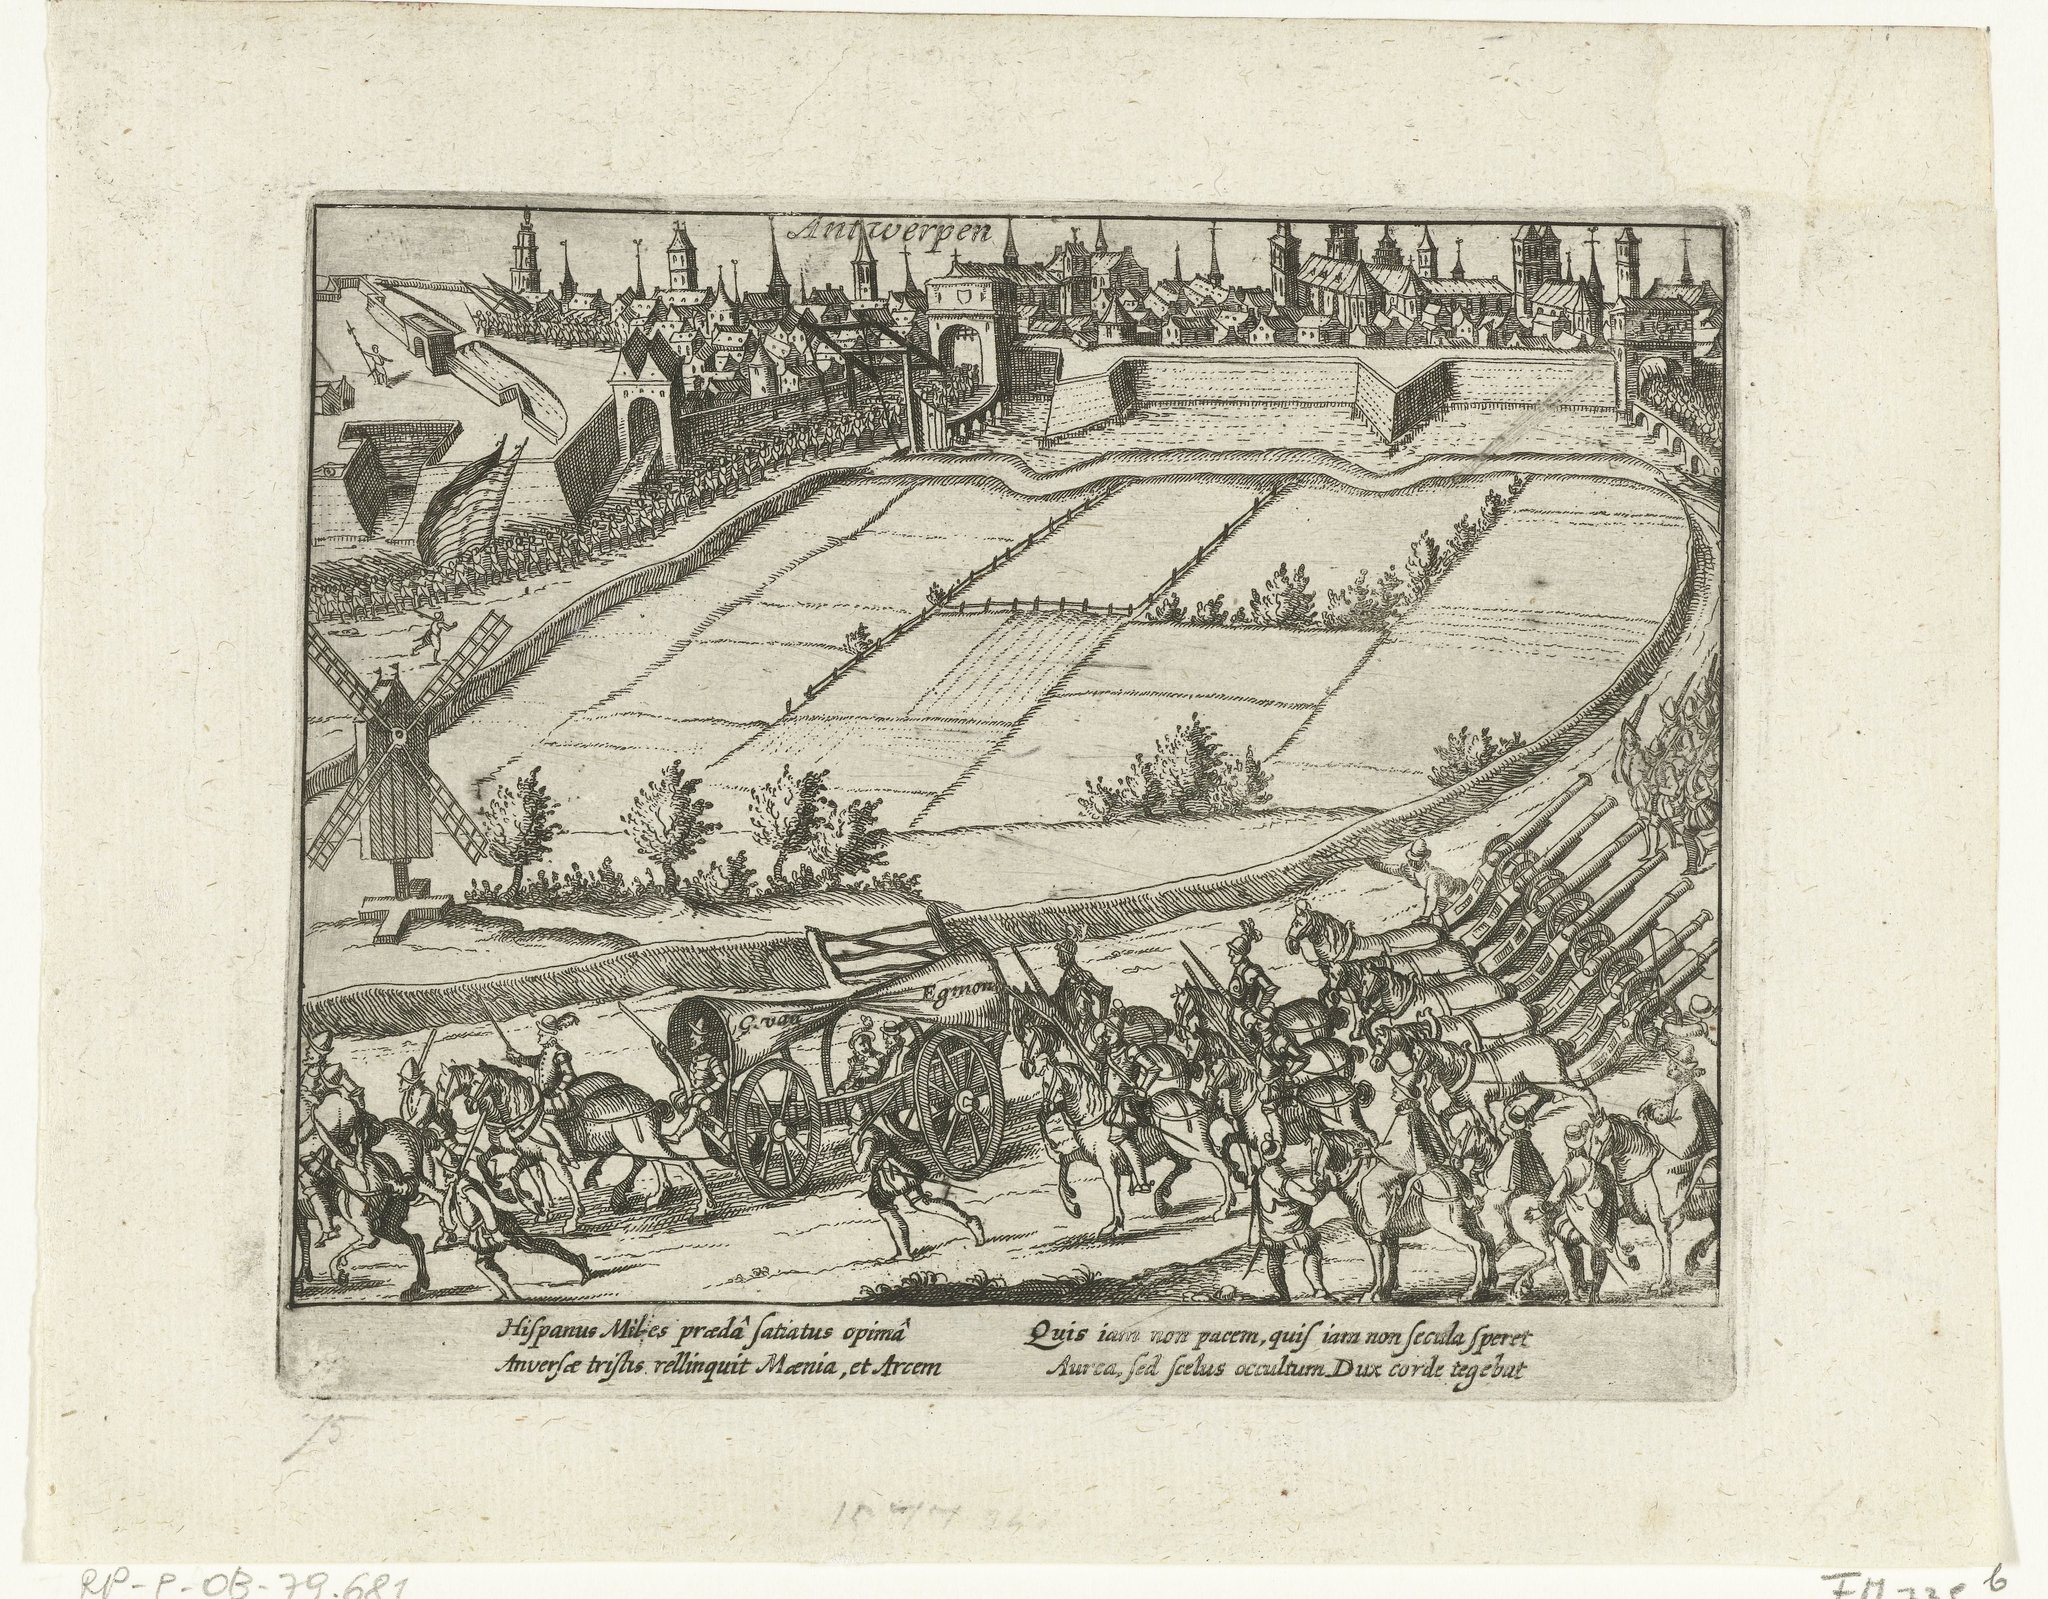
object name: print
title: Aftocht van Spanjaarden uit Antwerpen, 1577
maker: Anonymous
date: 1613-1615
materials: paper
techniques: pen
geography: northern netherlands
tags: antwerp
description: Vertrek van de Spaanse troepen uit Antwerpen, 20 maart 1577. Een lange stoet van soldaten, ruiters en kanonnen maar ook vrouwen en kinderen verlaat de stad. Op de voorgrond een koets met de graaf van Egmond. Links op de achtergrond trekken de troepen van de hertog van Aarschot de stad binnen. Met onderschrift van 4 regels in het Latijn. Genummerd: 75. Onbedrukt op achterzijde.